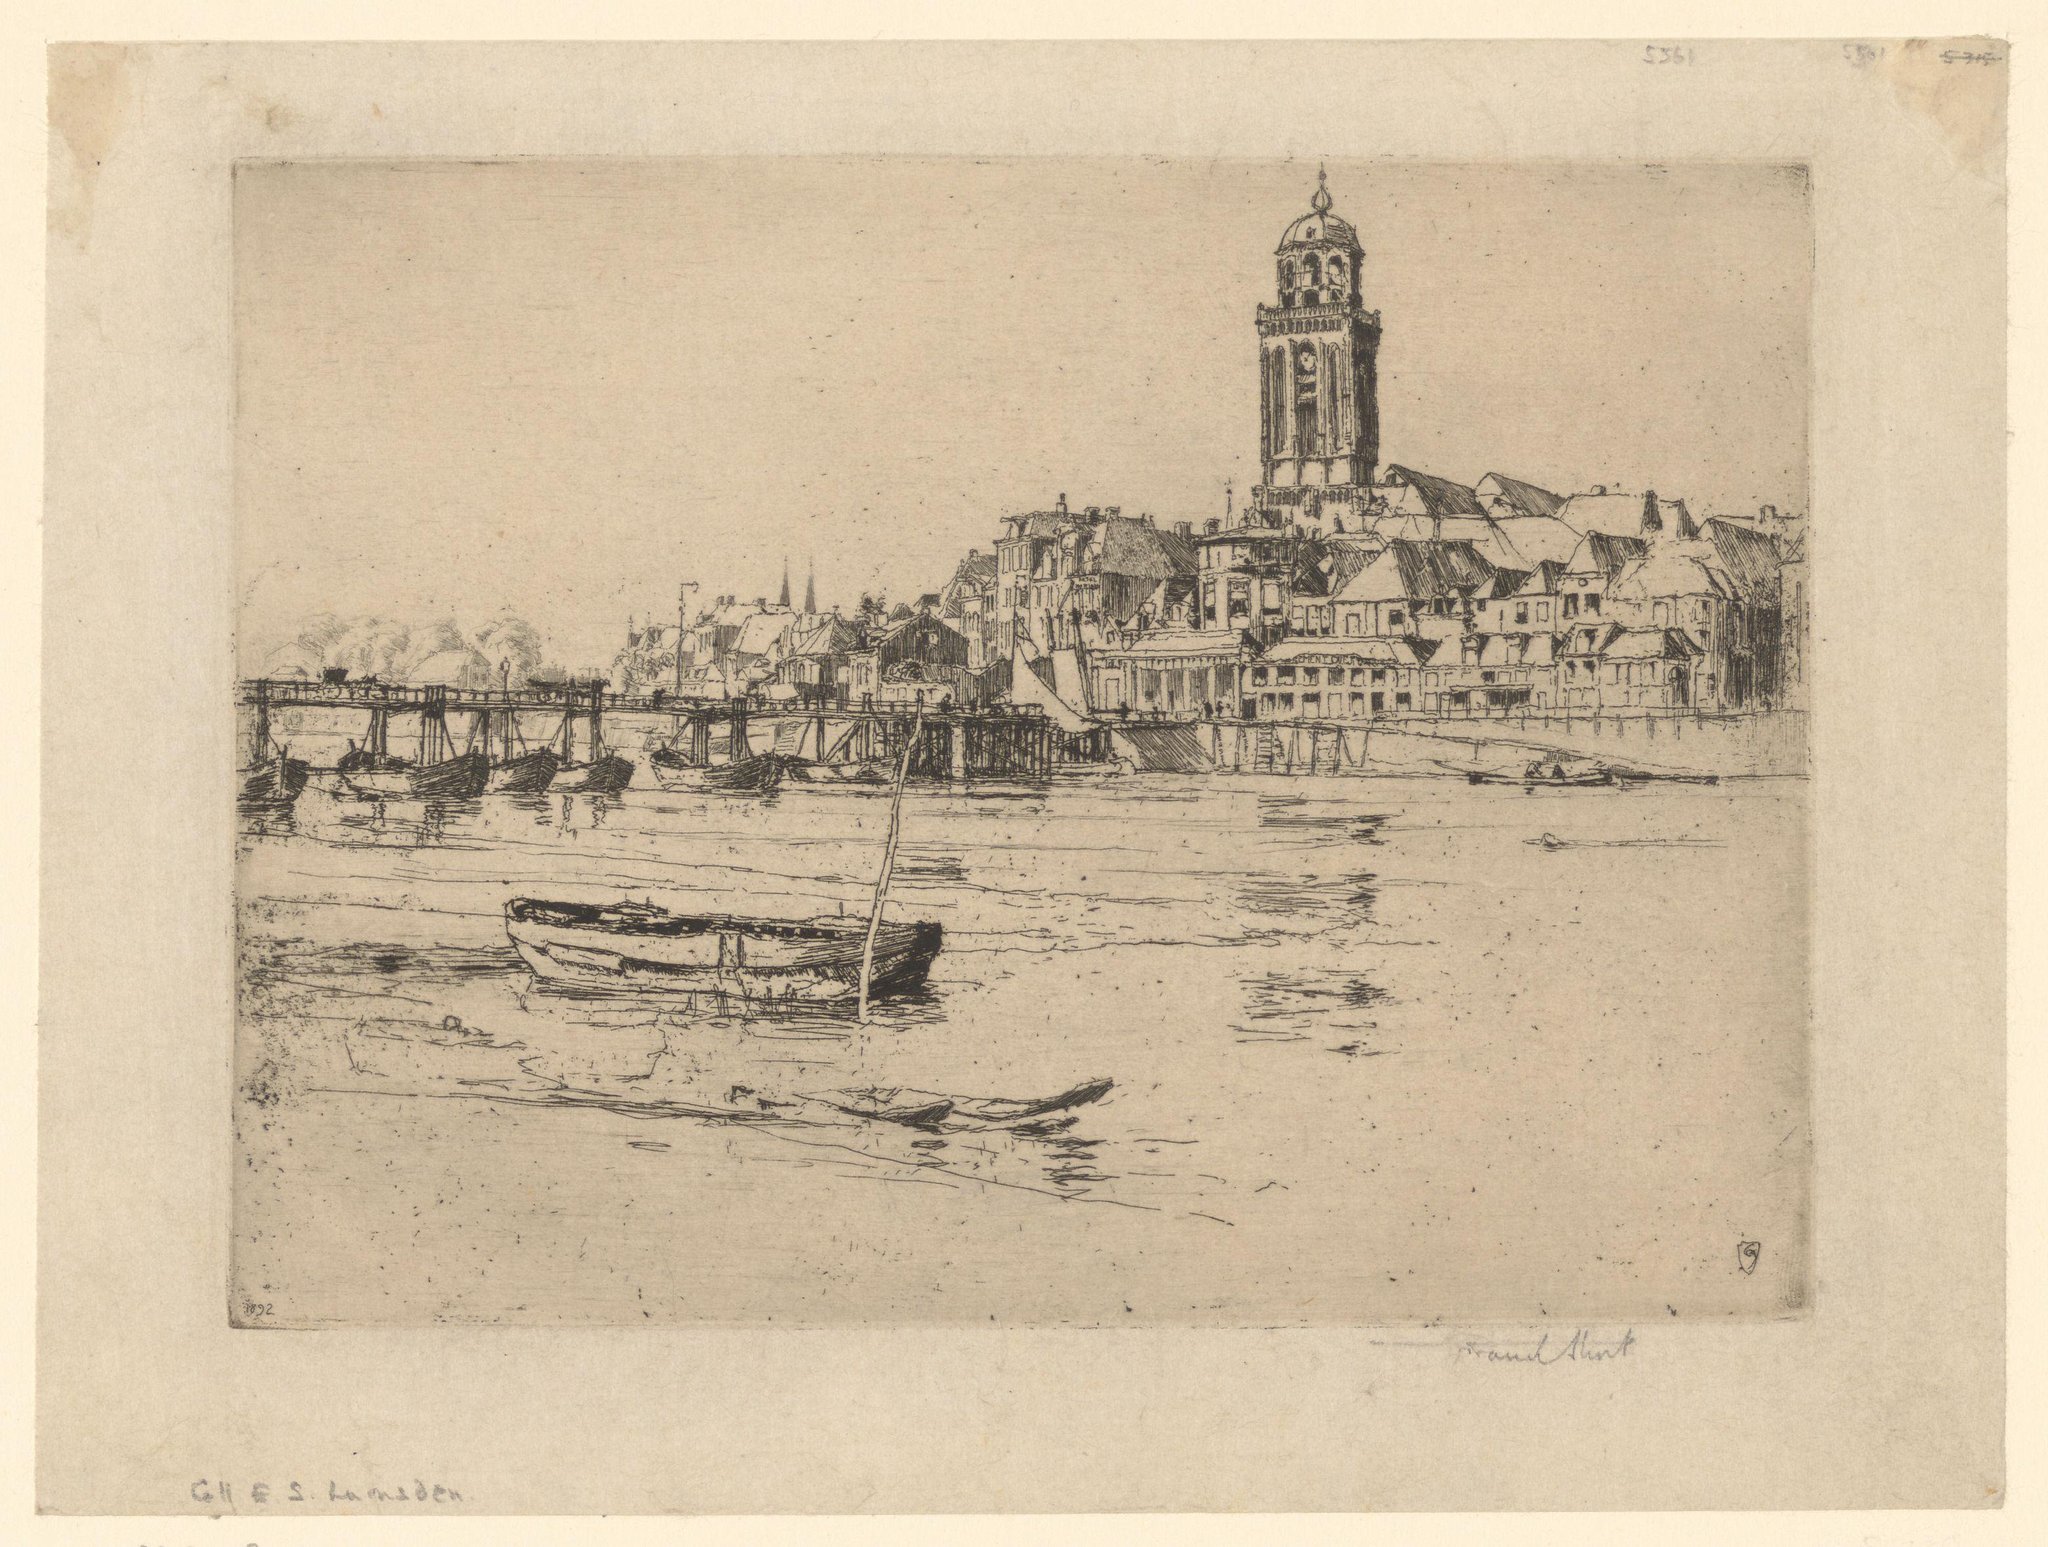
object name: print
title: Gezicht op Deventer met de Lebuïnuskerk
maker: frank short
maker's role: print maker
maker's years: 1857-1945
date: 1892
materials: paper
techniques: etching, intaglio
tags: city-view in general; 'veduta', river, church (exterior), deventer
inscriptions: collector's mark: Lugt 2760, collector's mark: Lugt 2228, signature: ‘Frank Short’